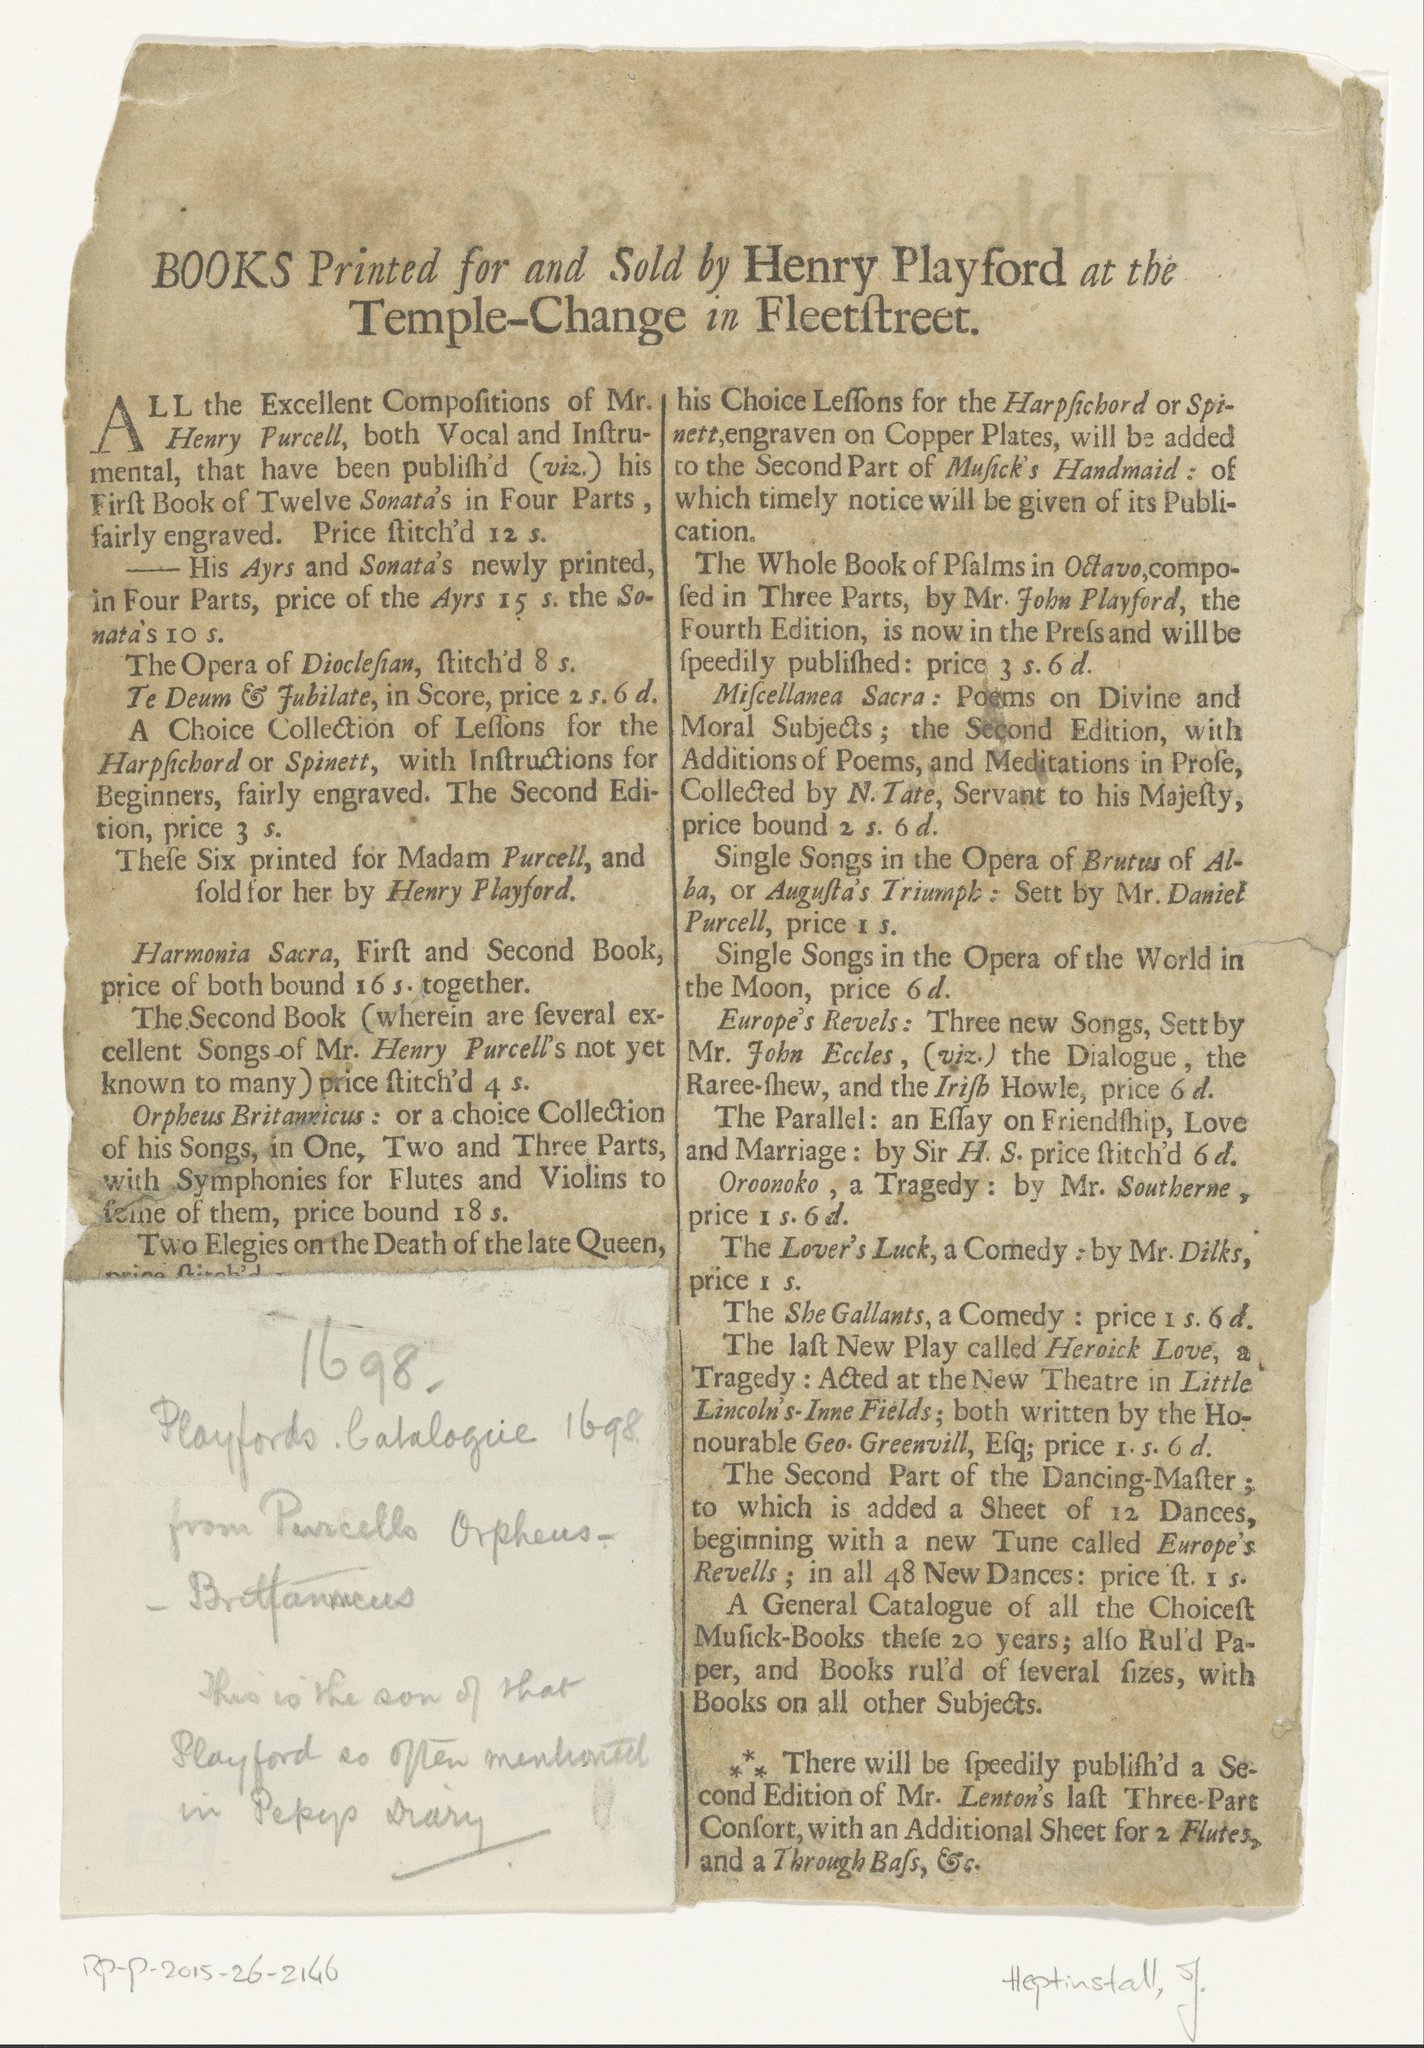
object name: fondslijst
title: Uitgeverscatalogus van Henry Playford te Londen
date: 1698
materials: paper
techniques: letterpress printing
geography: london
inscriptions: collector's mark: Lugt 2228, collector's mark: Lugt 4779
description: Dit blad is de verso zijde van de catalogus van Henry Playford, afkomstig uit: Purcell, Henry. Orpheus Britannicus. A Collection of all the Choicest Songs for One, Two, and Three Voices. Londen: Henry Playford, 1698.